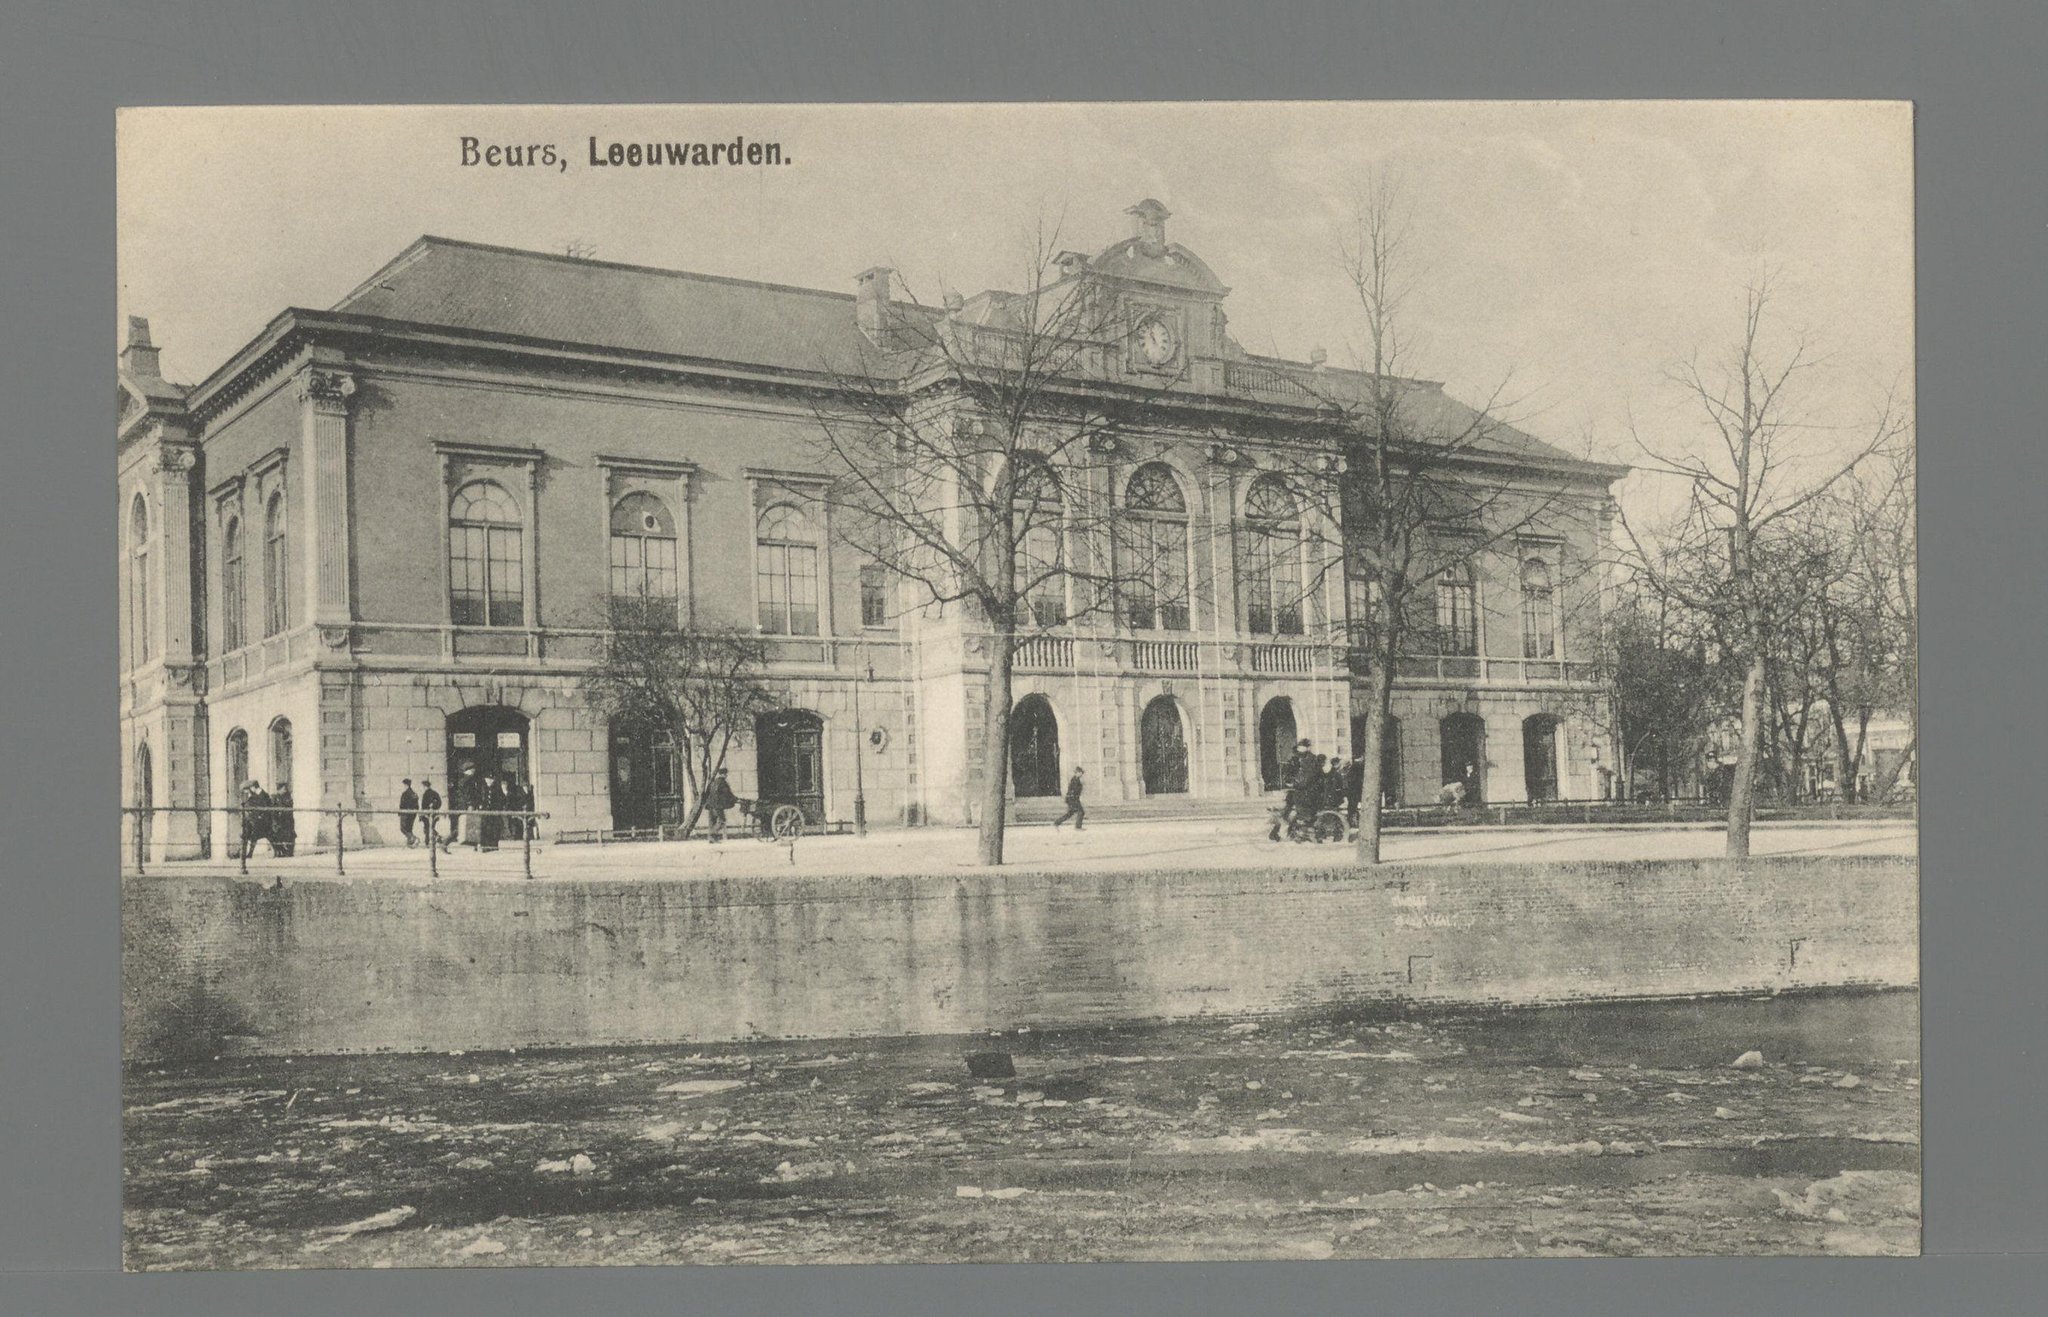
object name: ansichtkaart, prentbriefkaart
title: Beurs, Leeuwarden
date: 1905-1930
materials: cardboard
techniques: photograph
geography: leeuwarden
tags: canal, stock exchange, stock-market